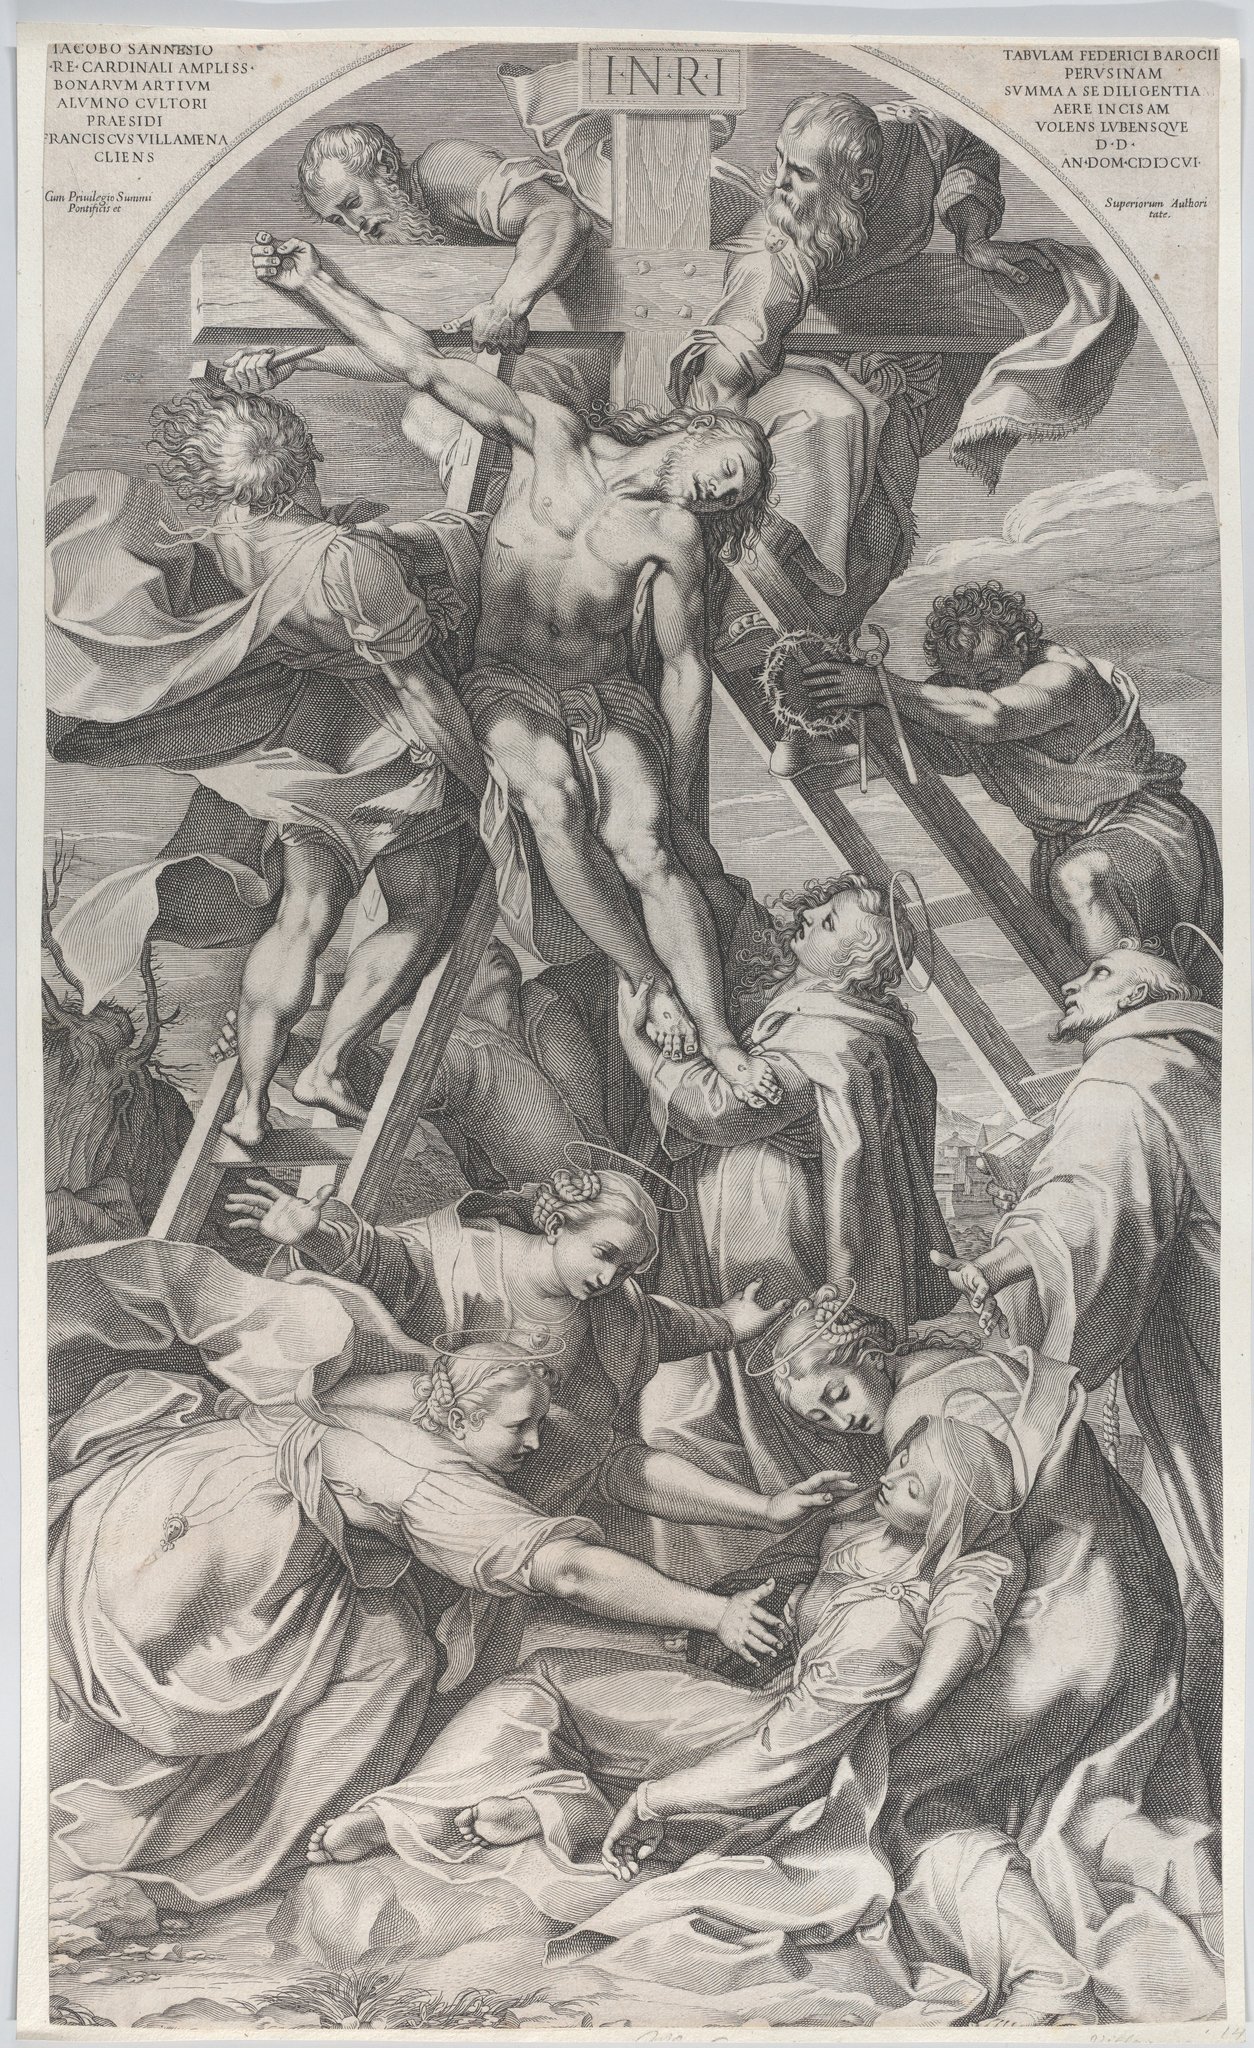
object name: print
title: The Descent from the Cross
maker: francesco villamena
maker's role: artist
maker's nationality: italian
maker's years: 1565-1624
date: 1606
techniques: engraving